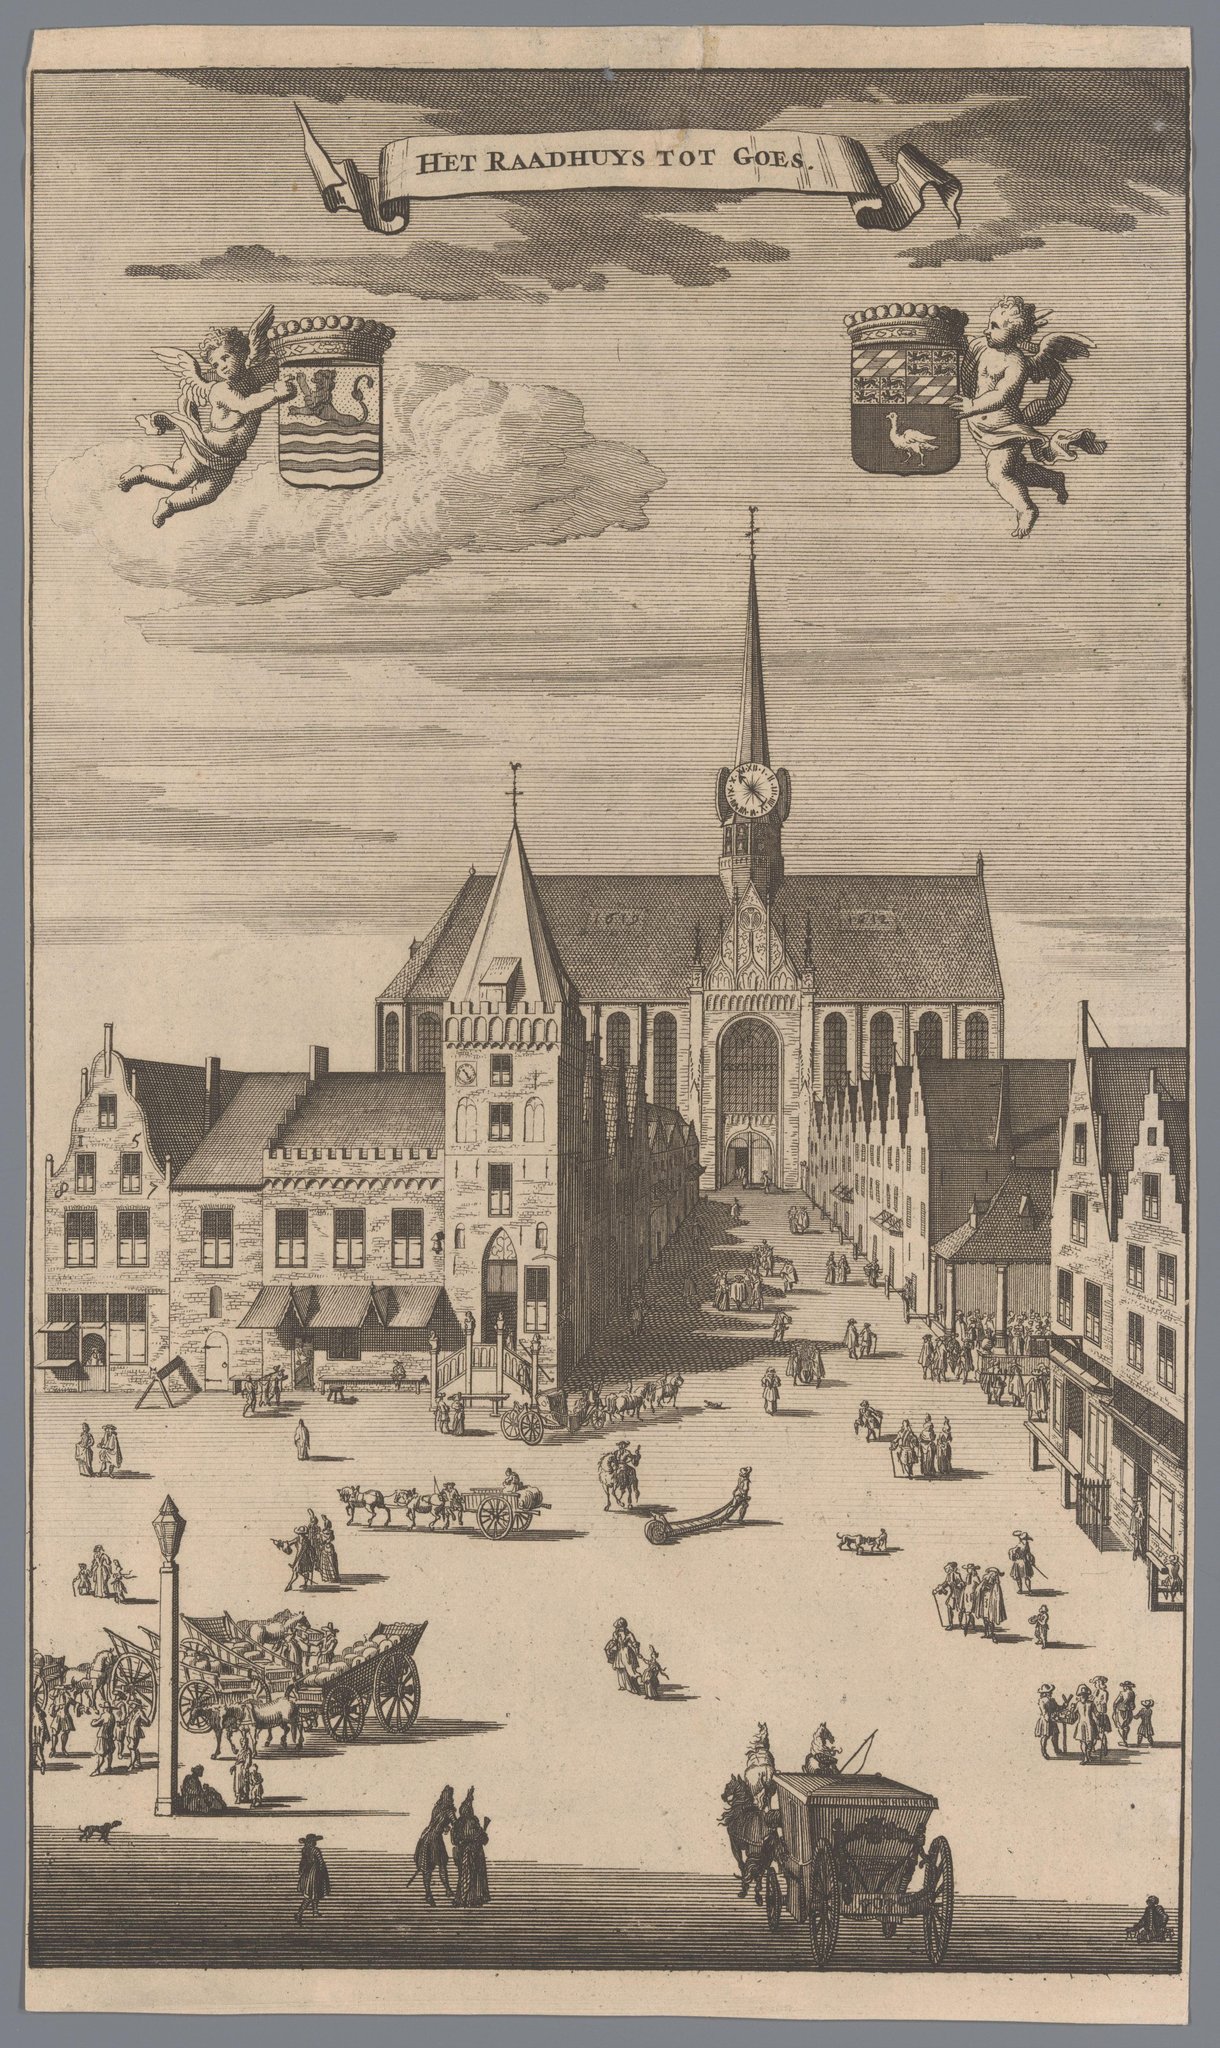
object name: print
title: Het Raadhuys tot Goes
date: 1696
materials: paper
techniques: engraving, etching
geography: middelburg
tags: city-view, and landscape with man-made constructions, townhall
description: Prent uit: Smallegange, M. Nieuwe Cronyk van Zeeland. Middelburg: Johannes Meertens, Amsterdam: Abraham van Someren, 1696.